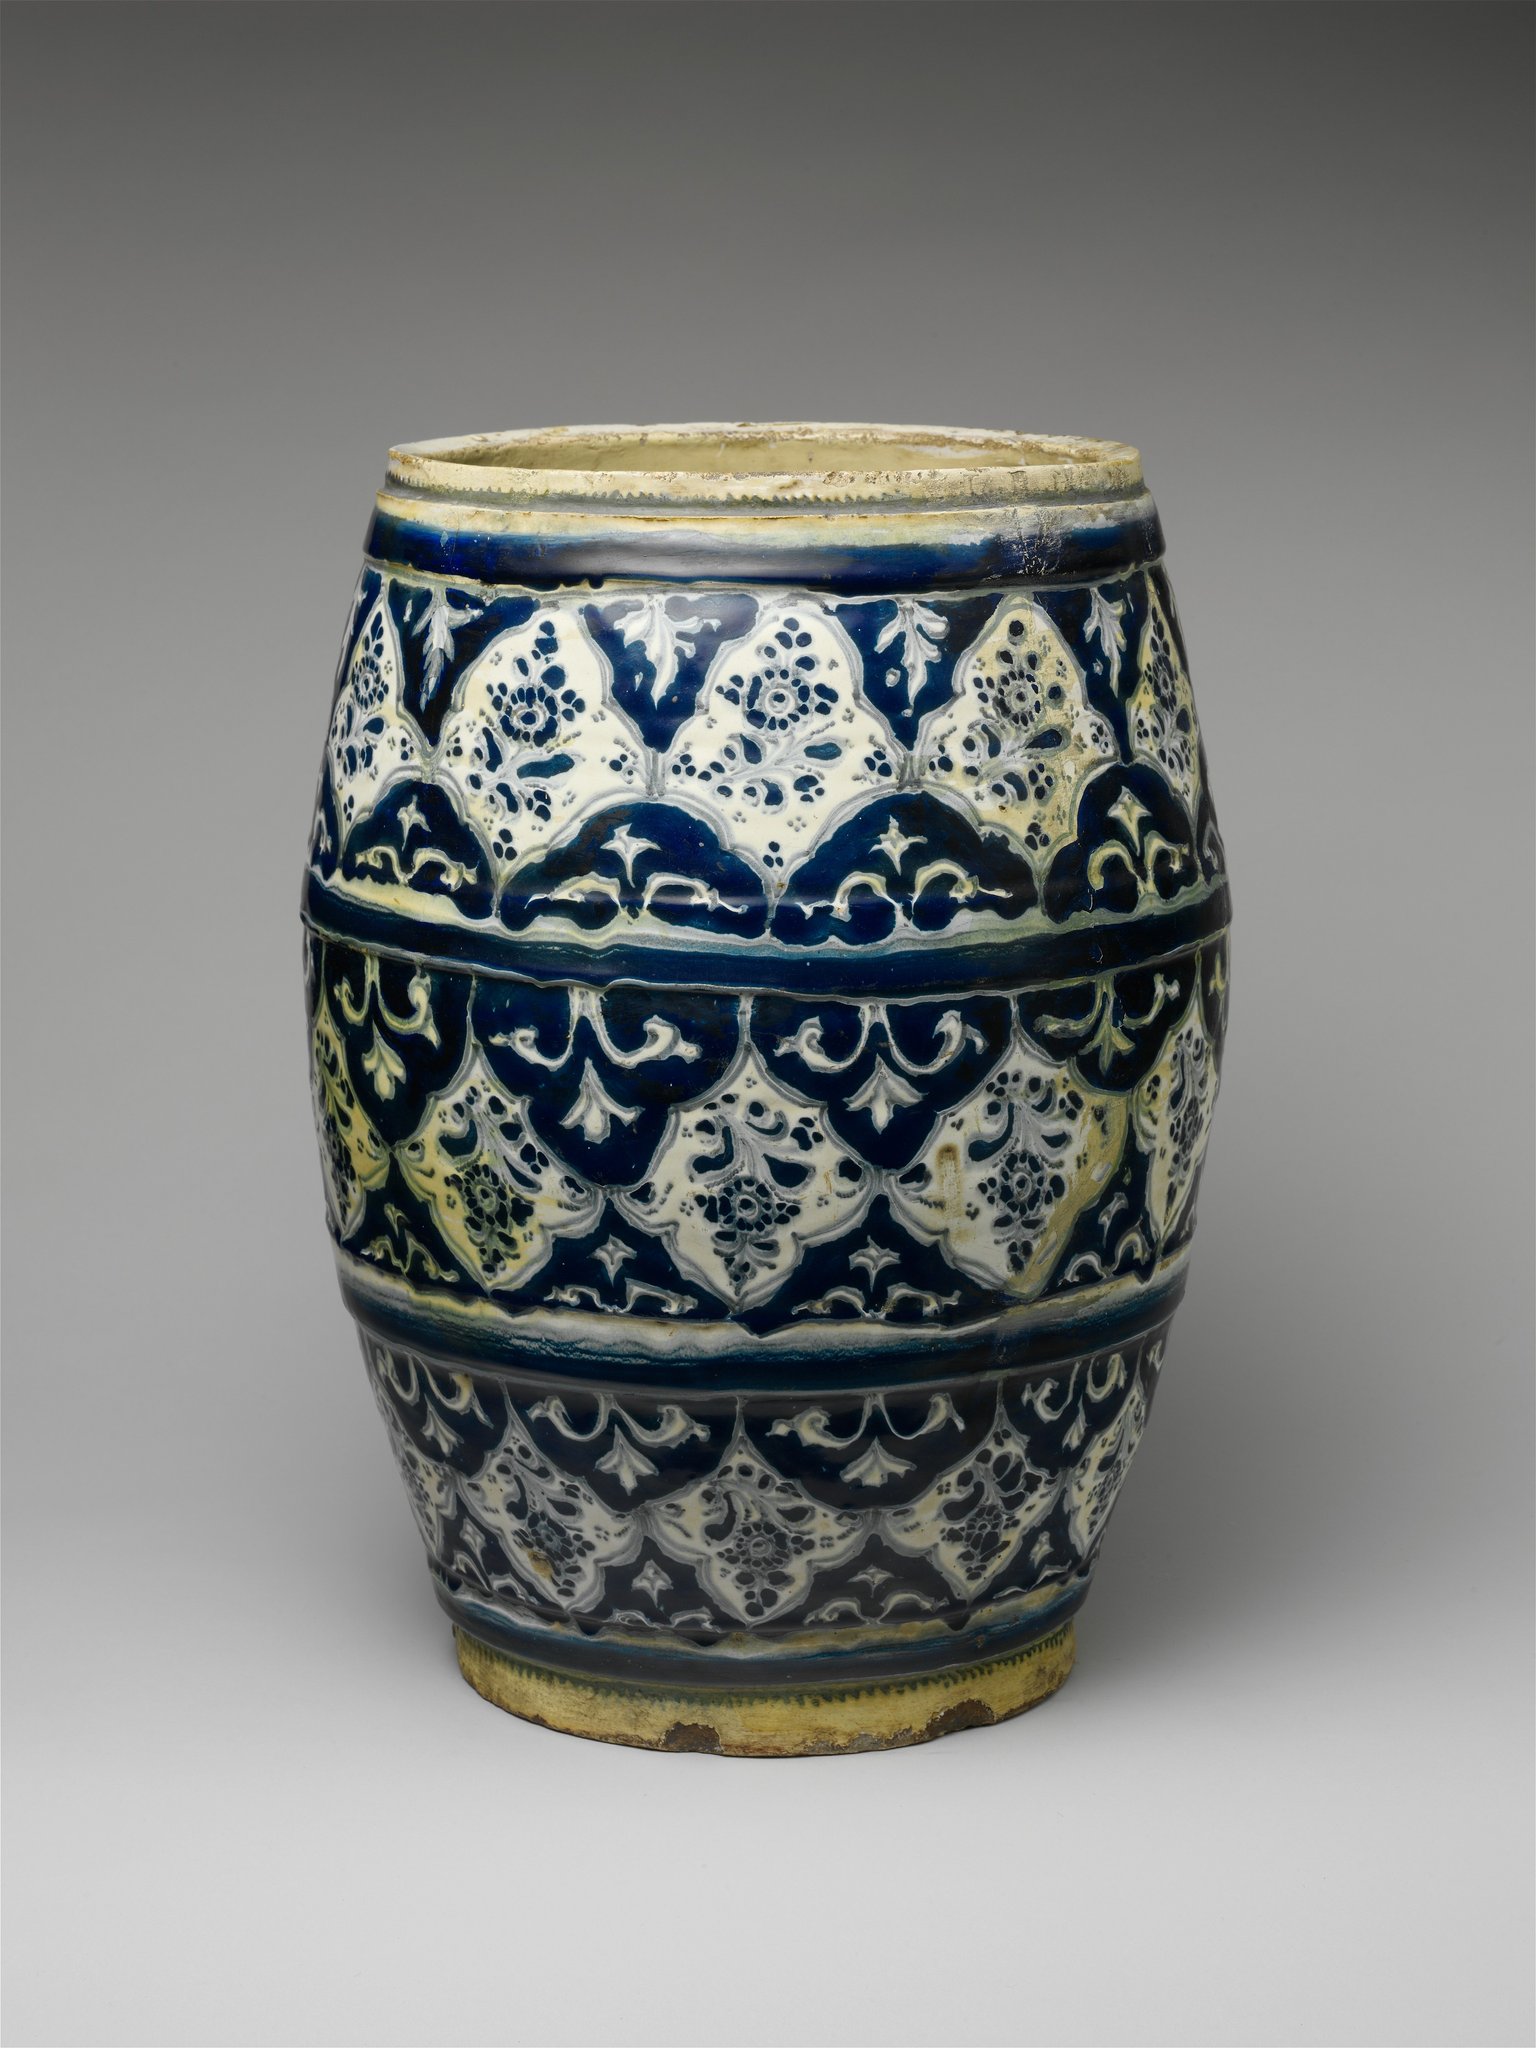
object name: flower pot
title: Barrel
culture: mexican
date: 1700-1750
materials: earthenware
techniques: glazing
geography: mexico